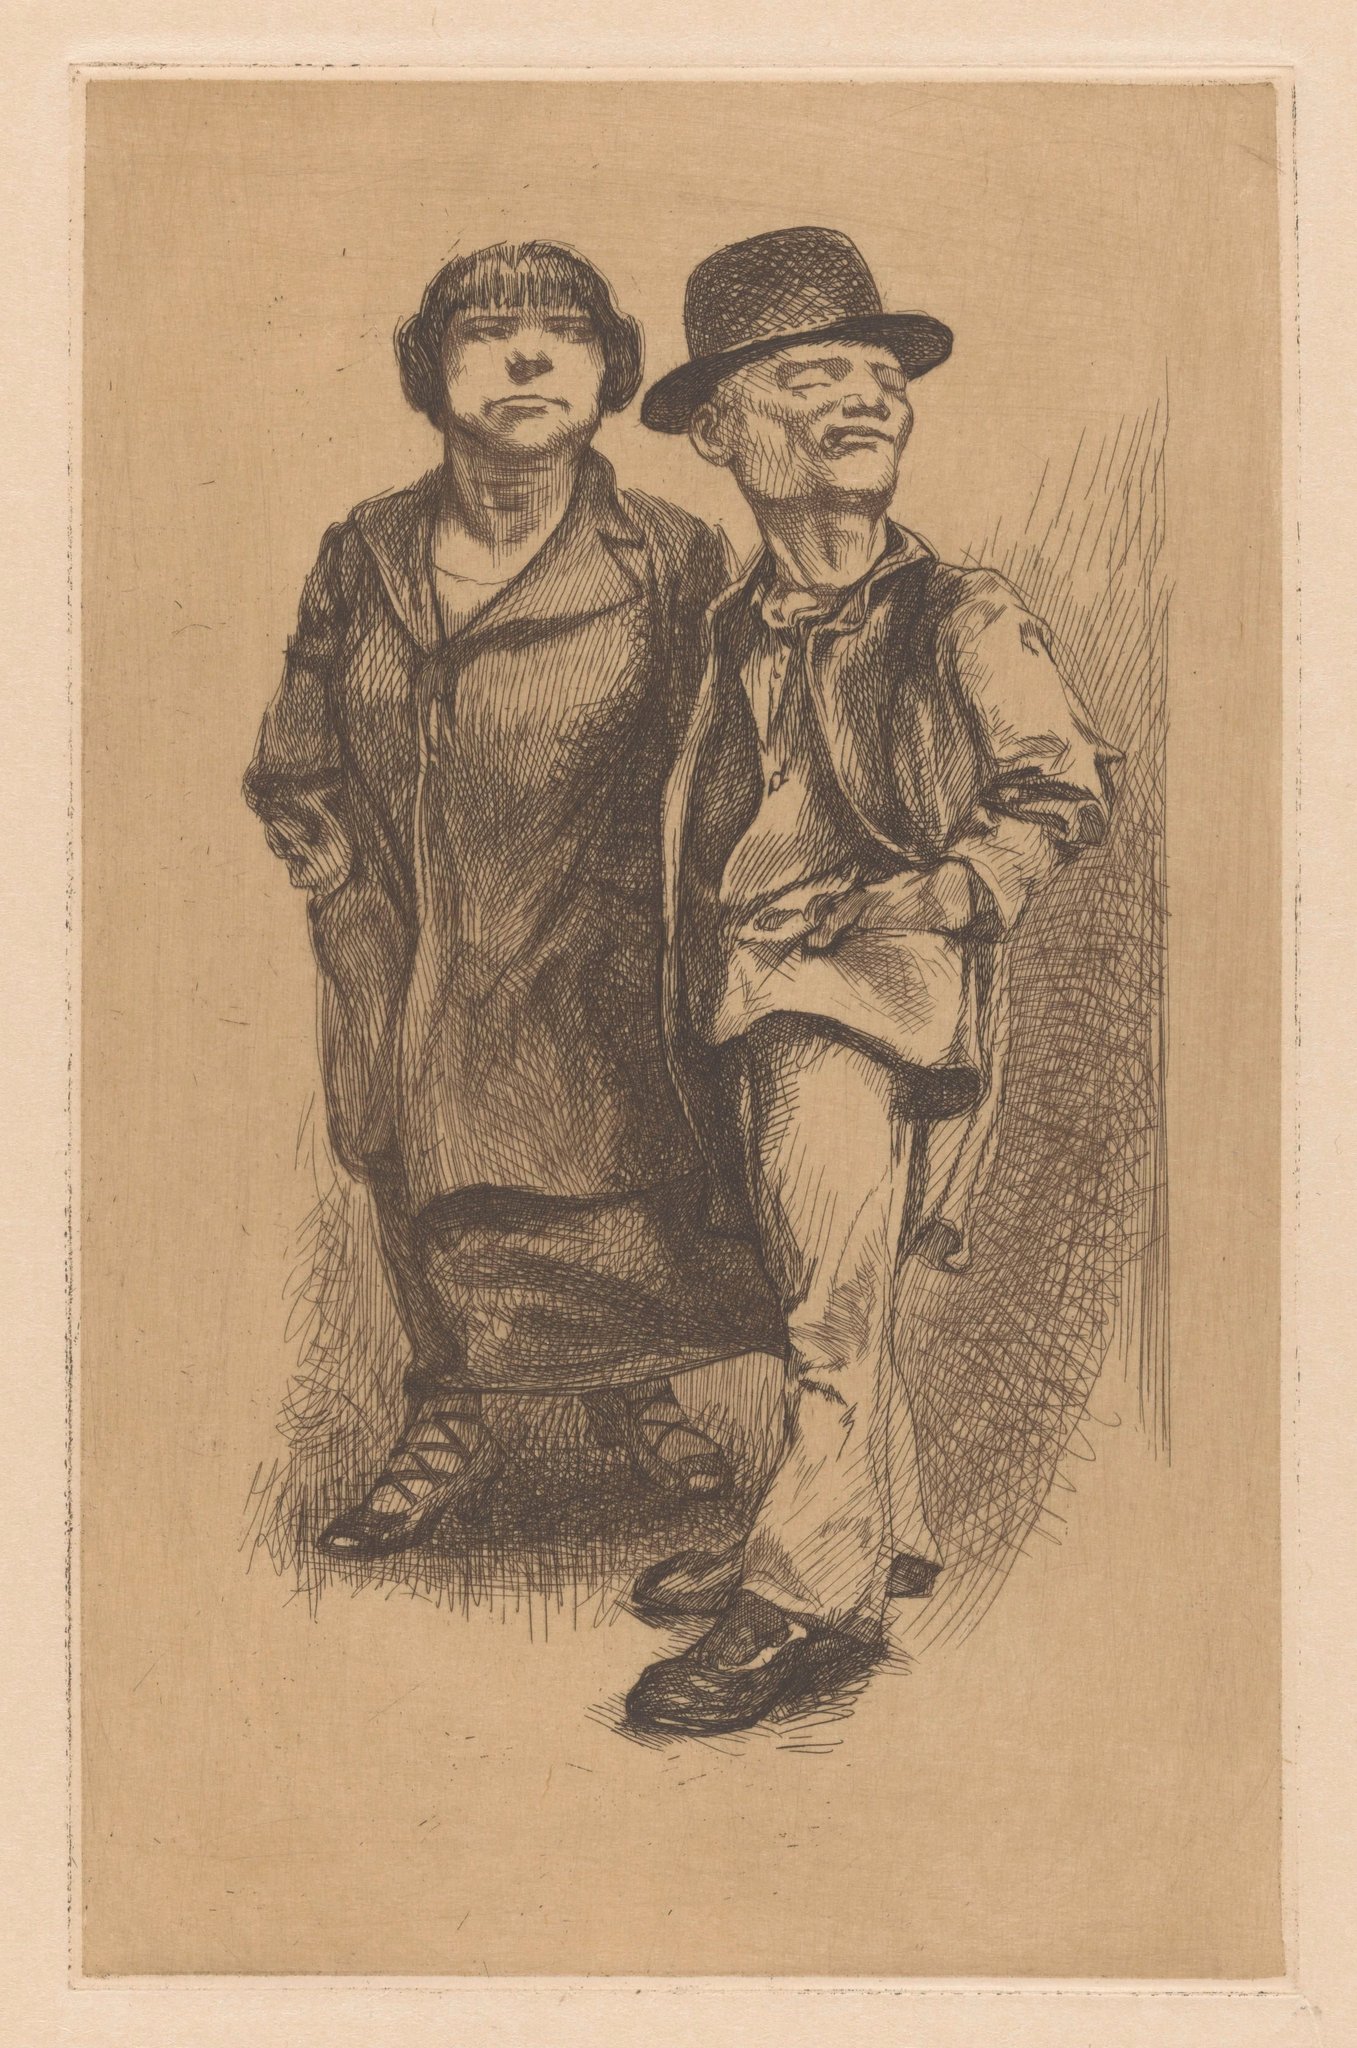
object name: print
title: Man met hoed en vrouw in jas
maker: johannes josephus aarts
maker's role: draughtsman, print maker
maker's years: 1871-1934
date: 1881-1934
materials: paper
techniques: etching, intaglio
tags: standing figure, head-gear: hat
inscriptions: collector's mark: Lugt 2760, collector's mark: Lugt 2228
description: Staande man met hoed, die zijn linkerhand in de zak van zijn vest heeft gestoken. Linksachter hem een vrouw in een jas met twee knotten in haar haar.